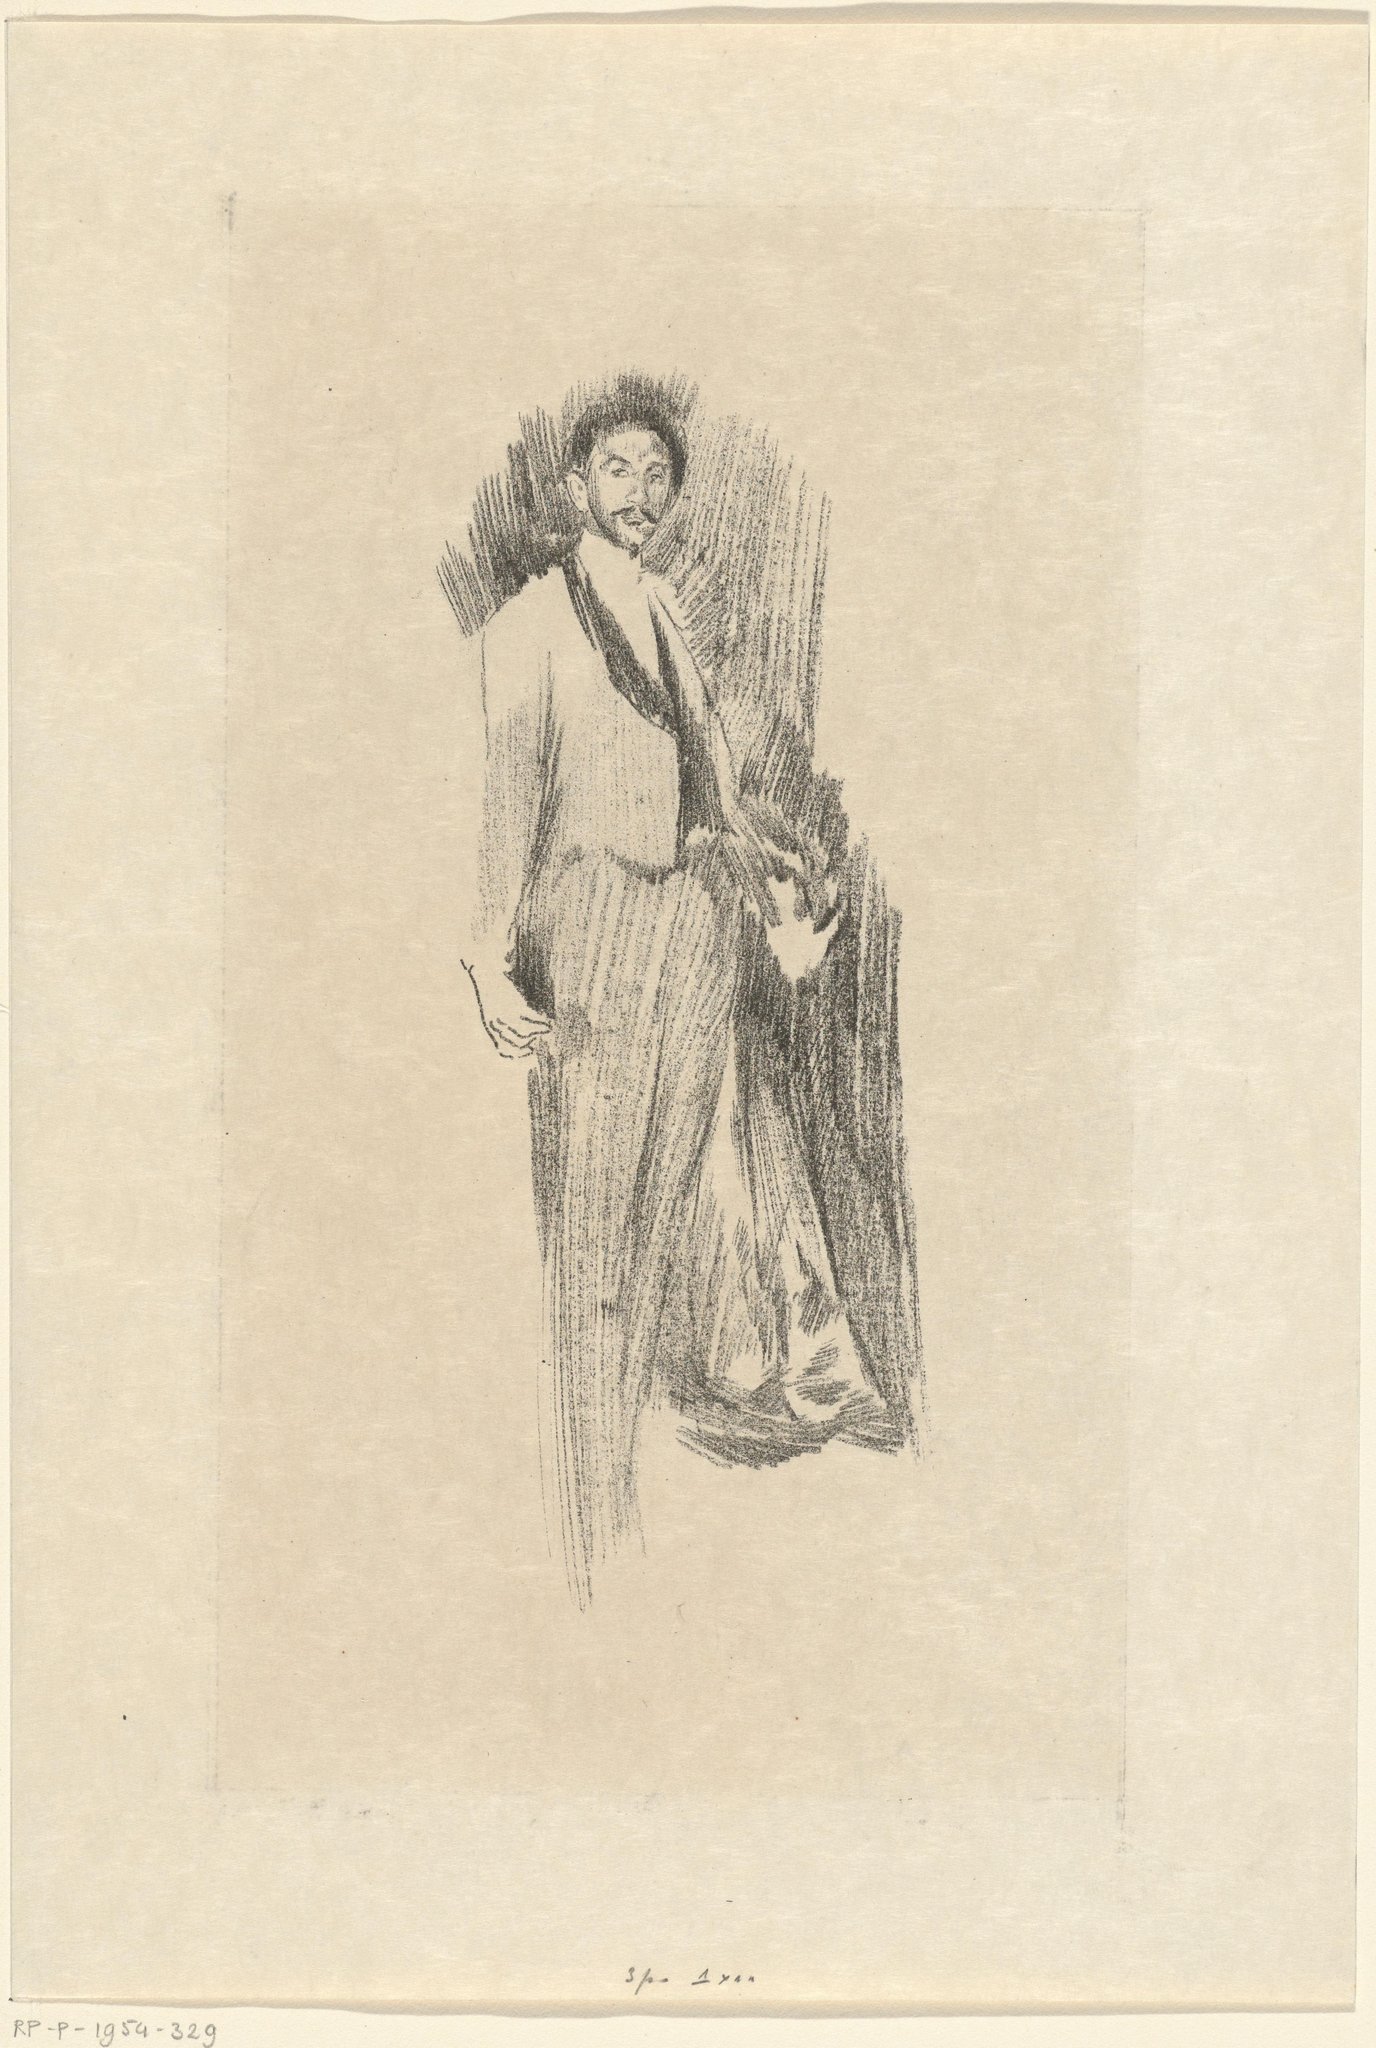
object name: print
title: Count Robert de Montesquiou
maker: james abbott mcneill whistler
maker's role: painter, print maker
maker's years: 1834-1903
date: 1895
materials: paper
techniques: lithograph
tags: paris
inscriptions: collector's mark: Lugt 2228, collector's mark: Lugt 2760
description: Portret van graaf Robert de Montesquion, staand, met een bontmantel over zijn linker arm.